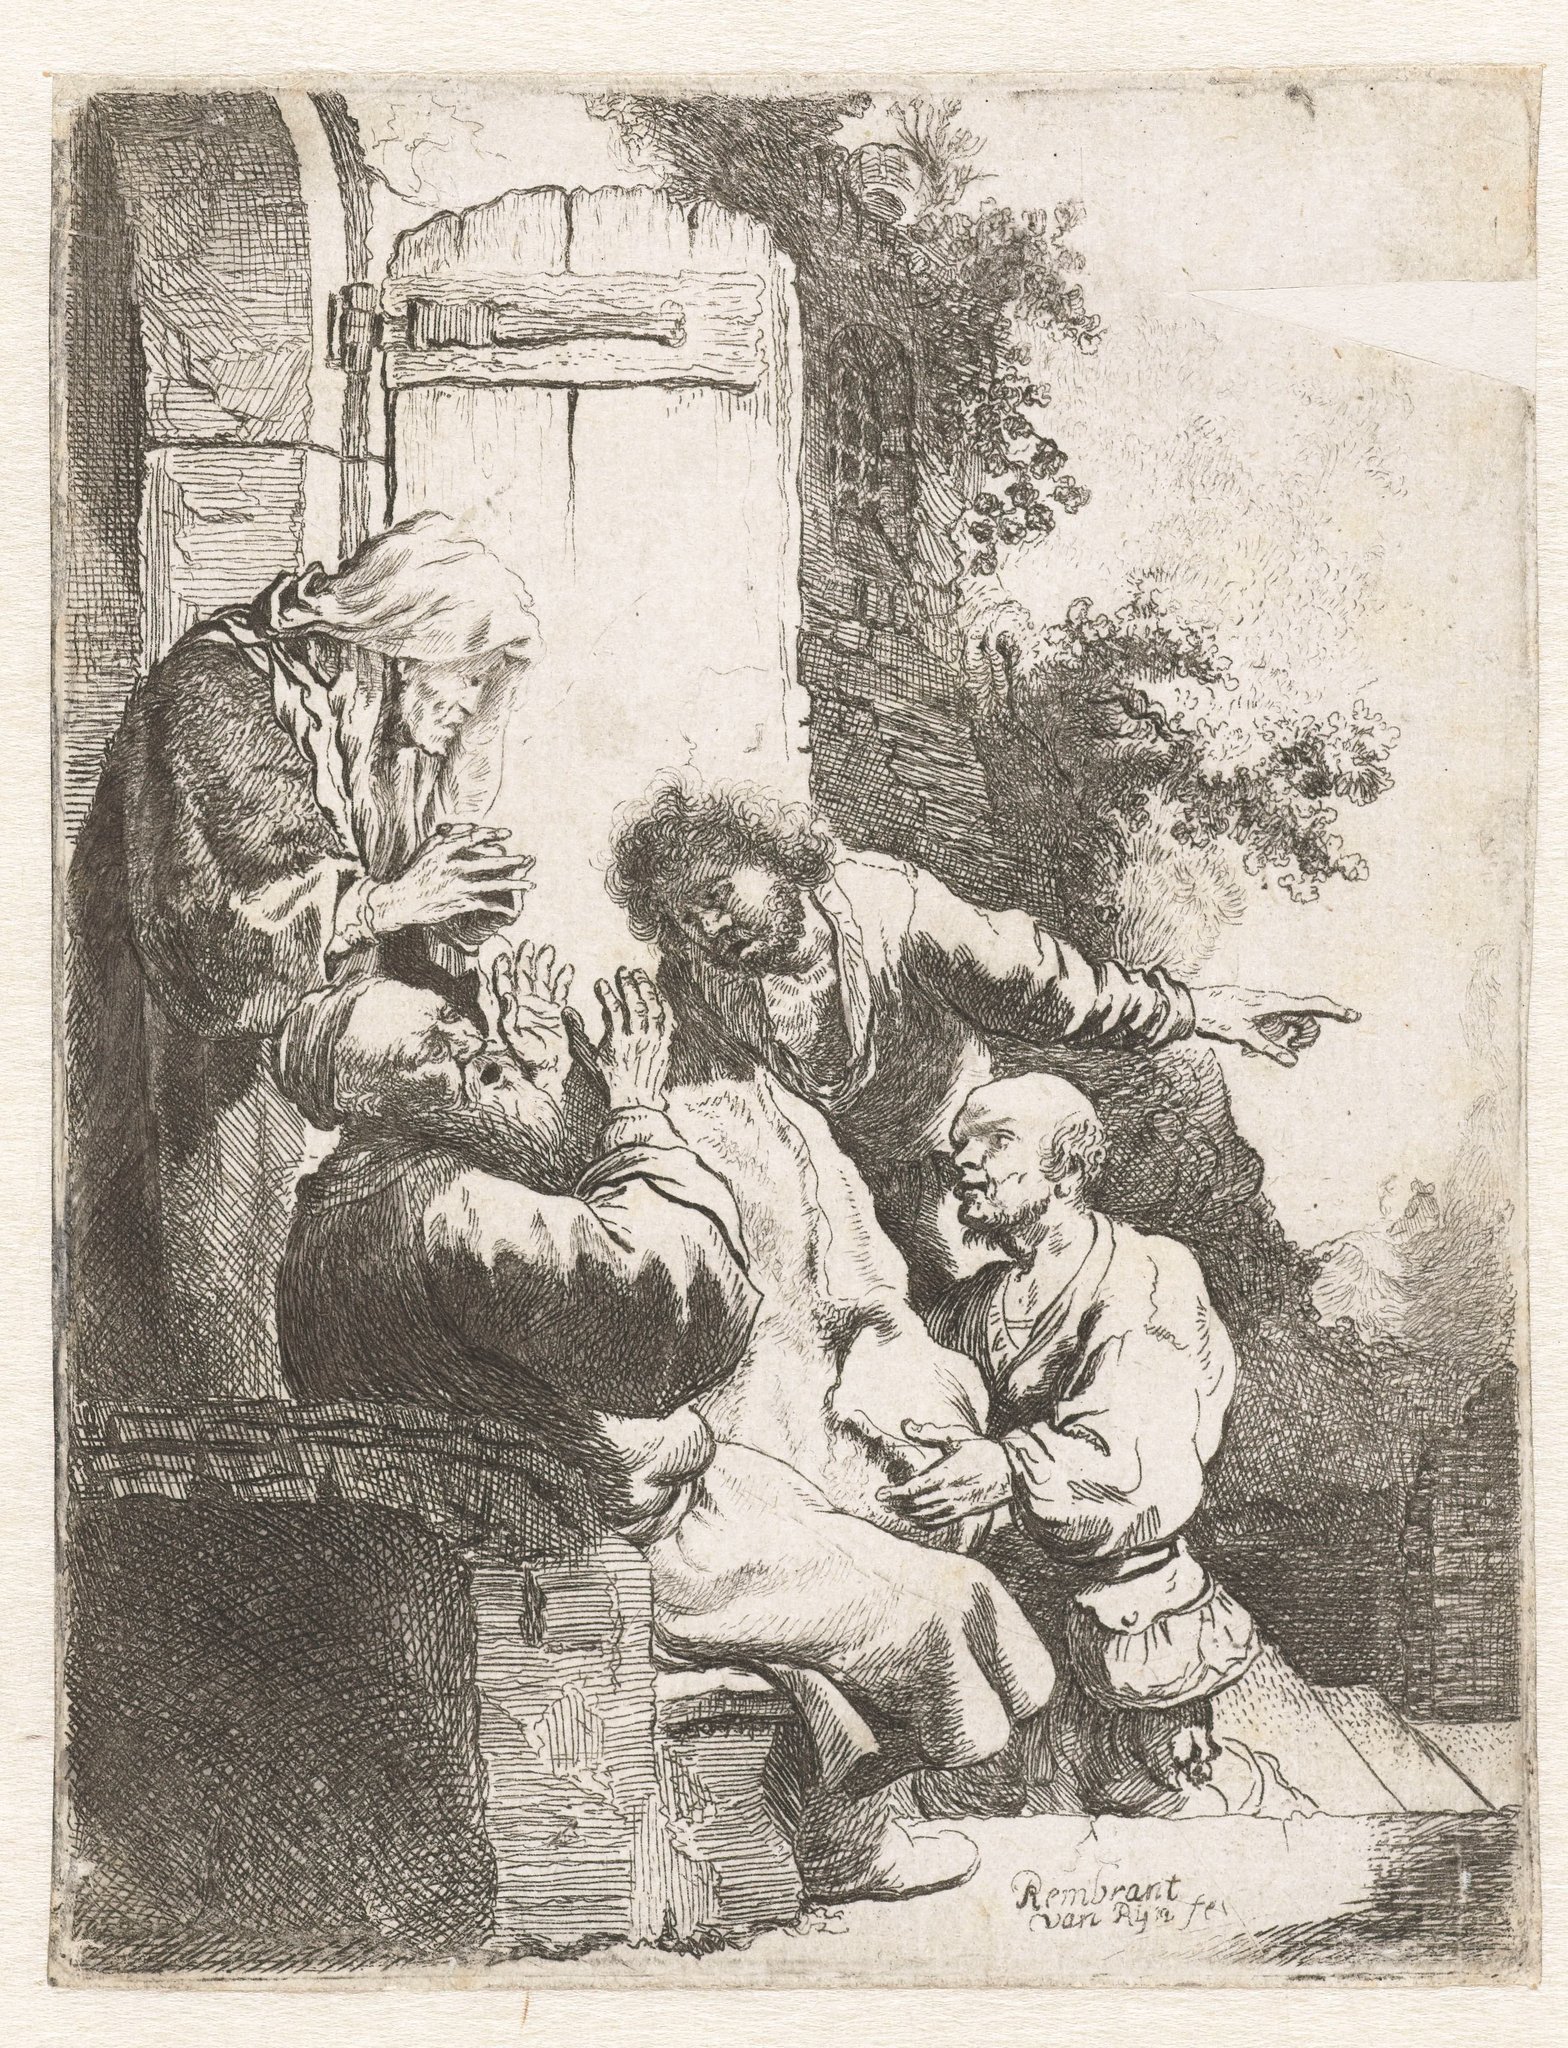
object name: print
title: Joseph's coat brought to Jacob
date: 1633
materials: paper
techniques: etching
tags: genesis: the story of joseph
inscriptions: collector's mark: Lugt 2760, collector's mark: Lugt 2228